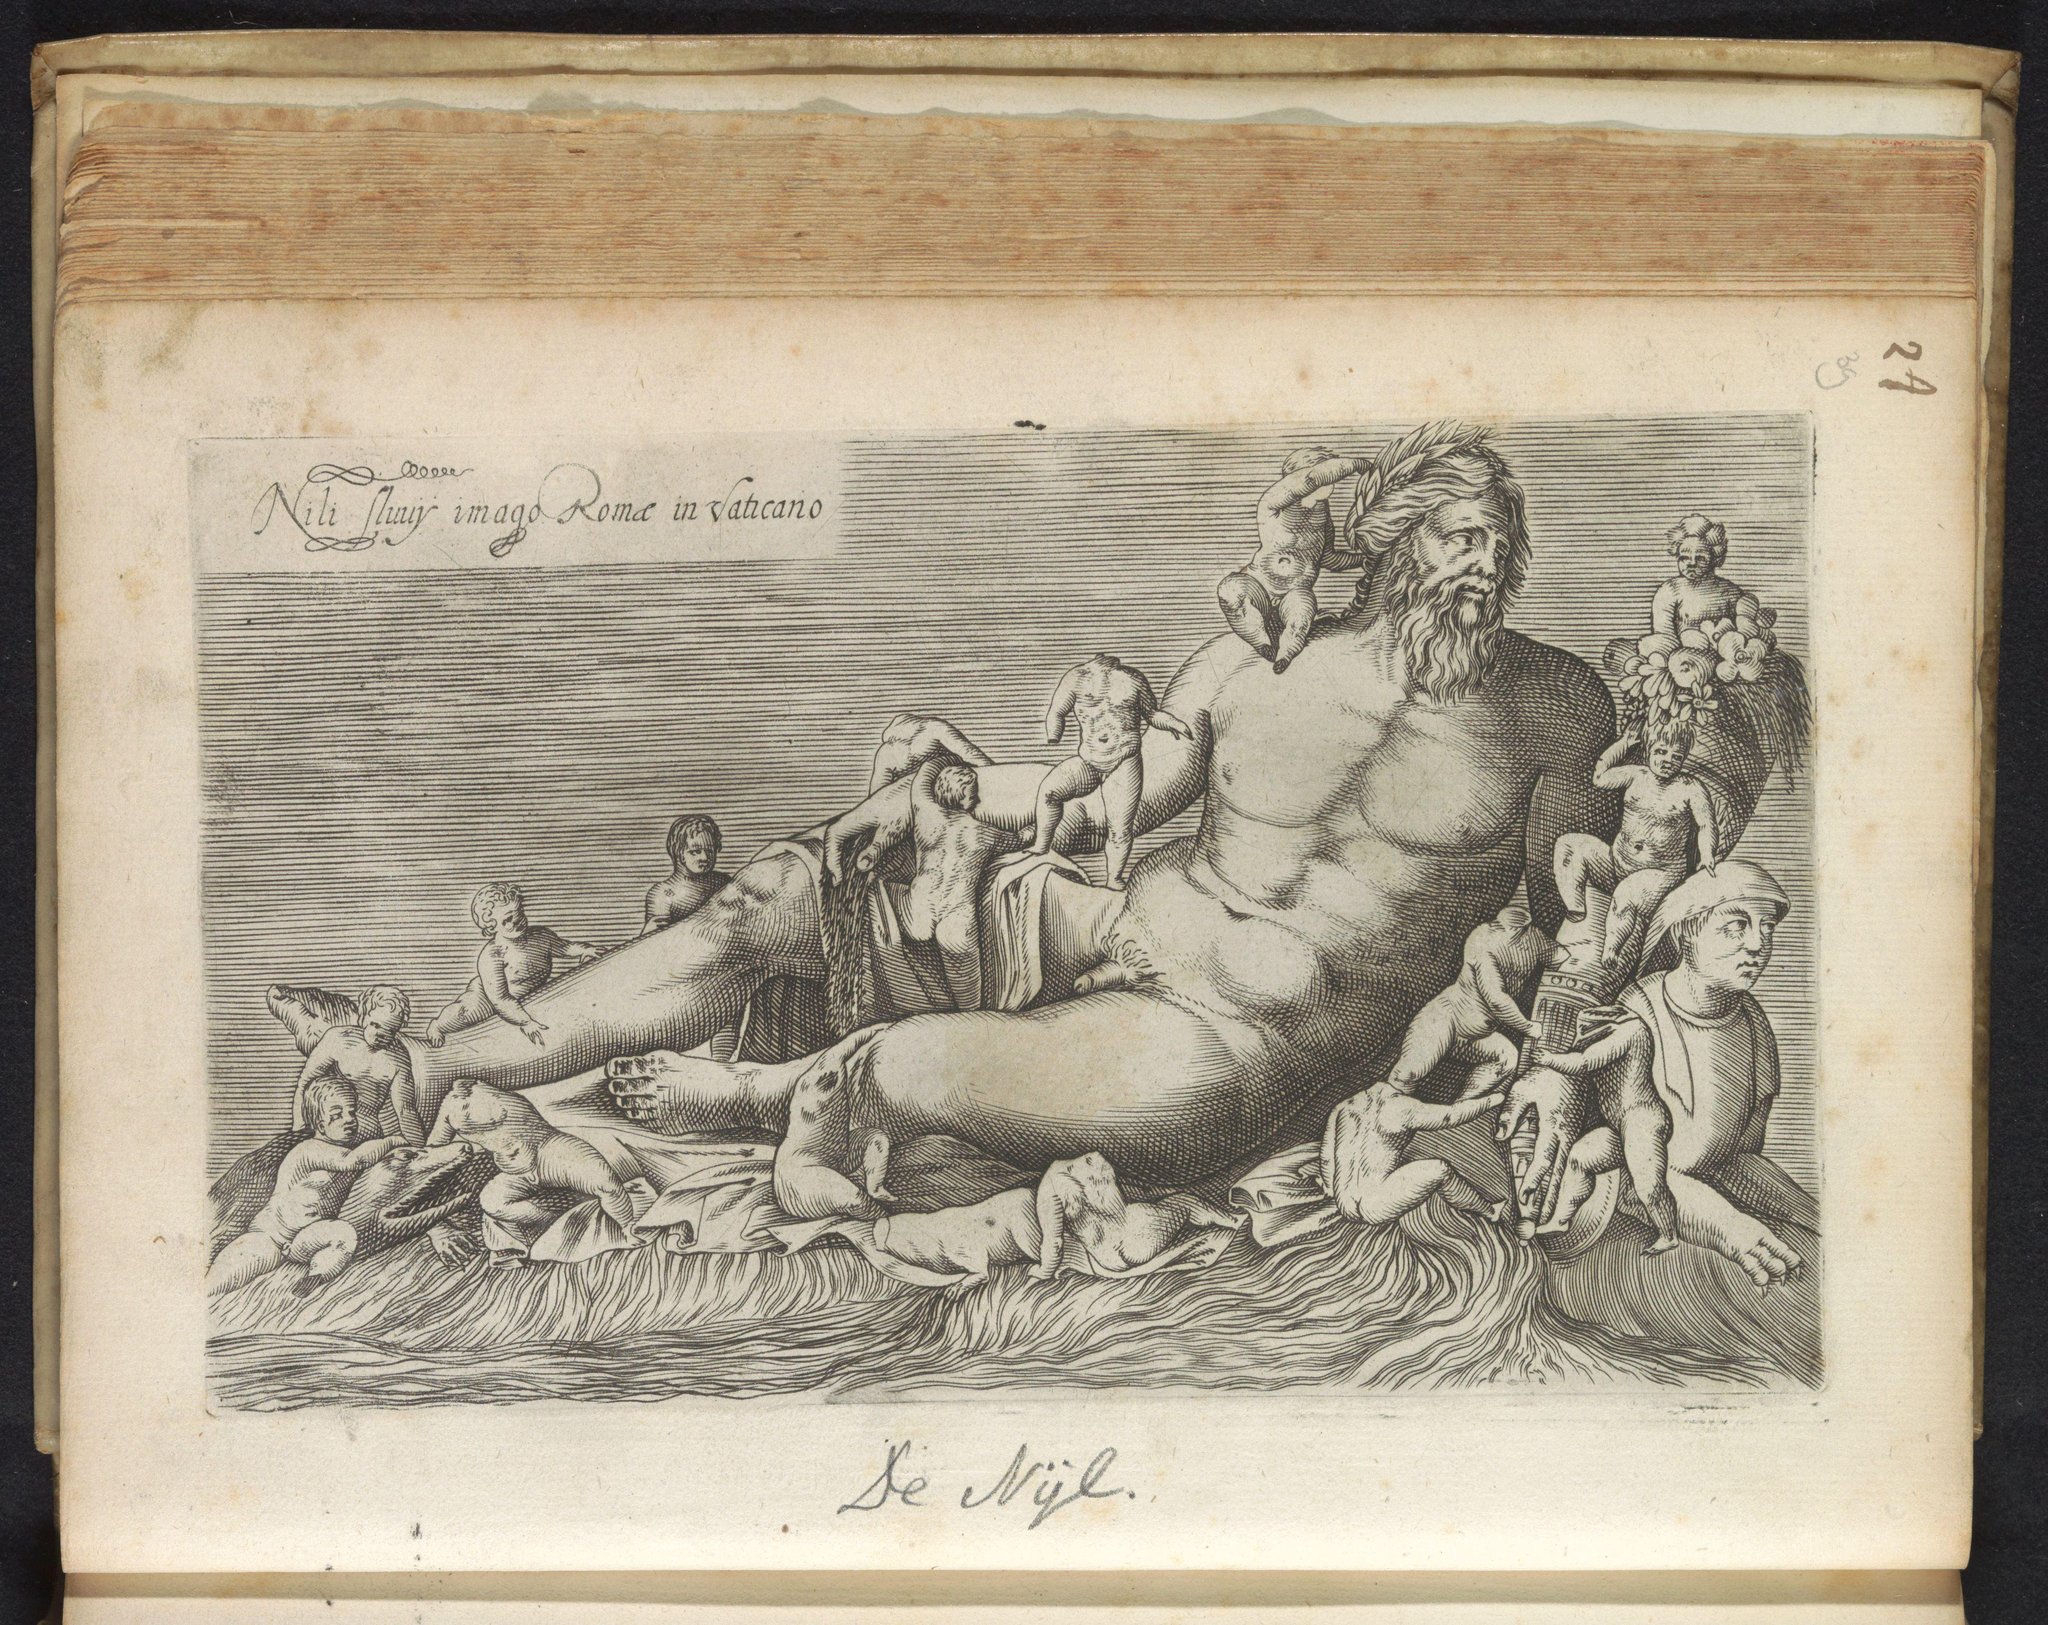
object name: print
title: Sculptuur van de rivier de Nijl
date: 1584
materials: paper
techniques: engraving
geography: italy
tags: piece of sculpture, reproduction of a piece of sculpture, personification of river nile; 'nilo' (ripa)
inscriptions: number: ‘24’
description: Beeld van de riviergod de Nijl met als attributen een hoorn met vruchten, een sfinx, krokodillen en kleine jongetjes. Titel in het Latijn linksboven. Prent maakt deel uit van een album.